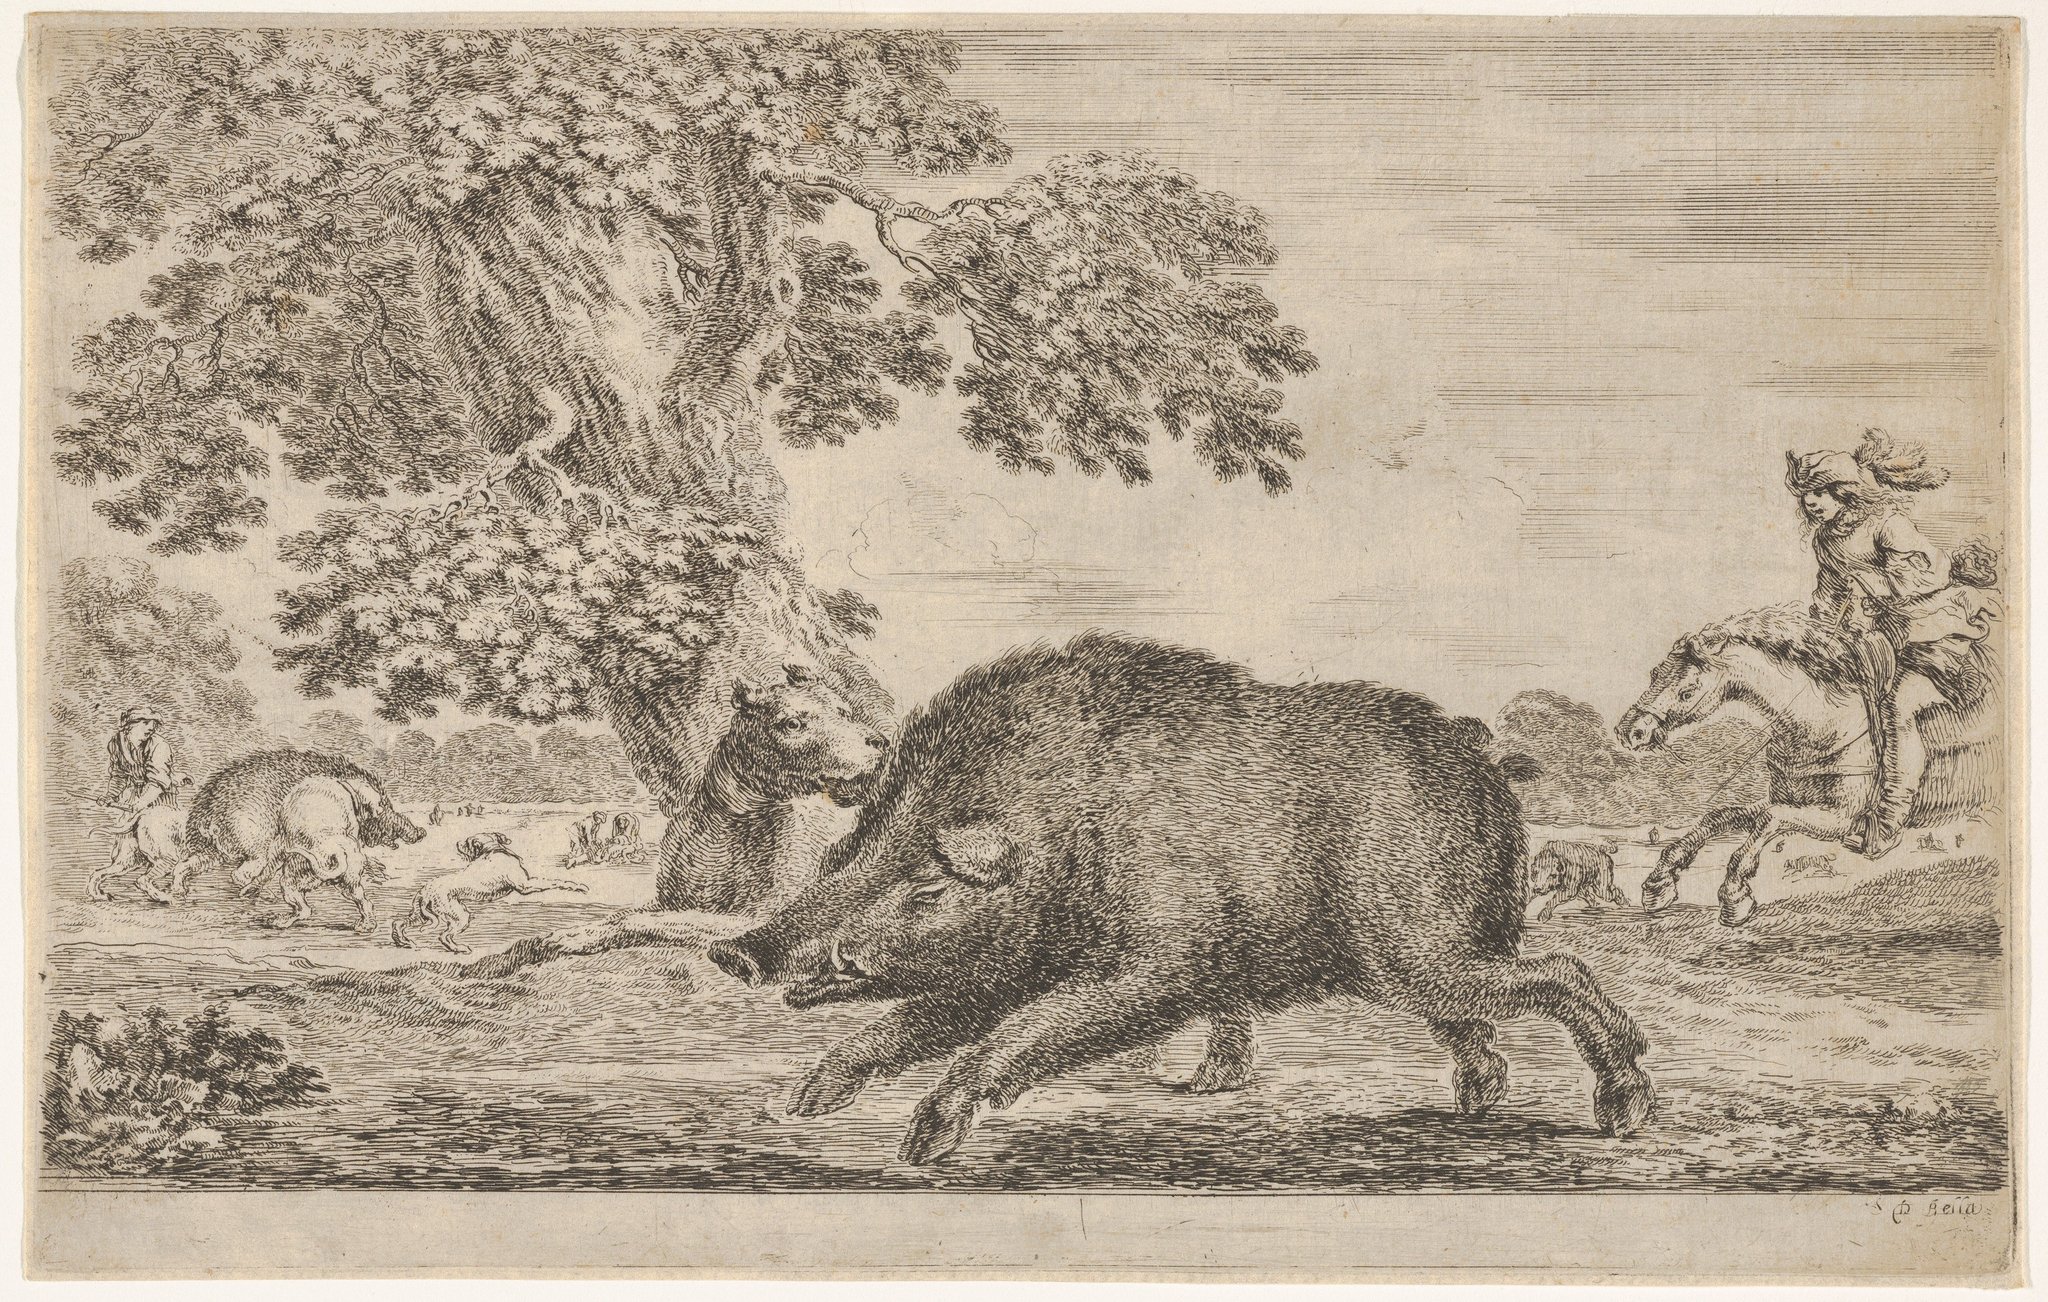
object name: print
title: A wild boar running towards the left, a dog biting its ear behind to left, other dogs and horsemen in the background, from "Hunts of various animals" (Chasses à différents animaux)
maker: stefano della bella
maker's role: artist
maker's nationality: italian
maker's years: 1610-1664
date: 1651-1657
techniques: etching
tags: men,boars,dogs,horses